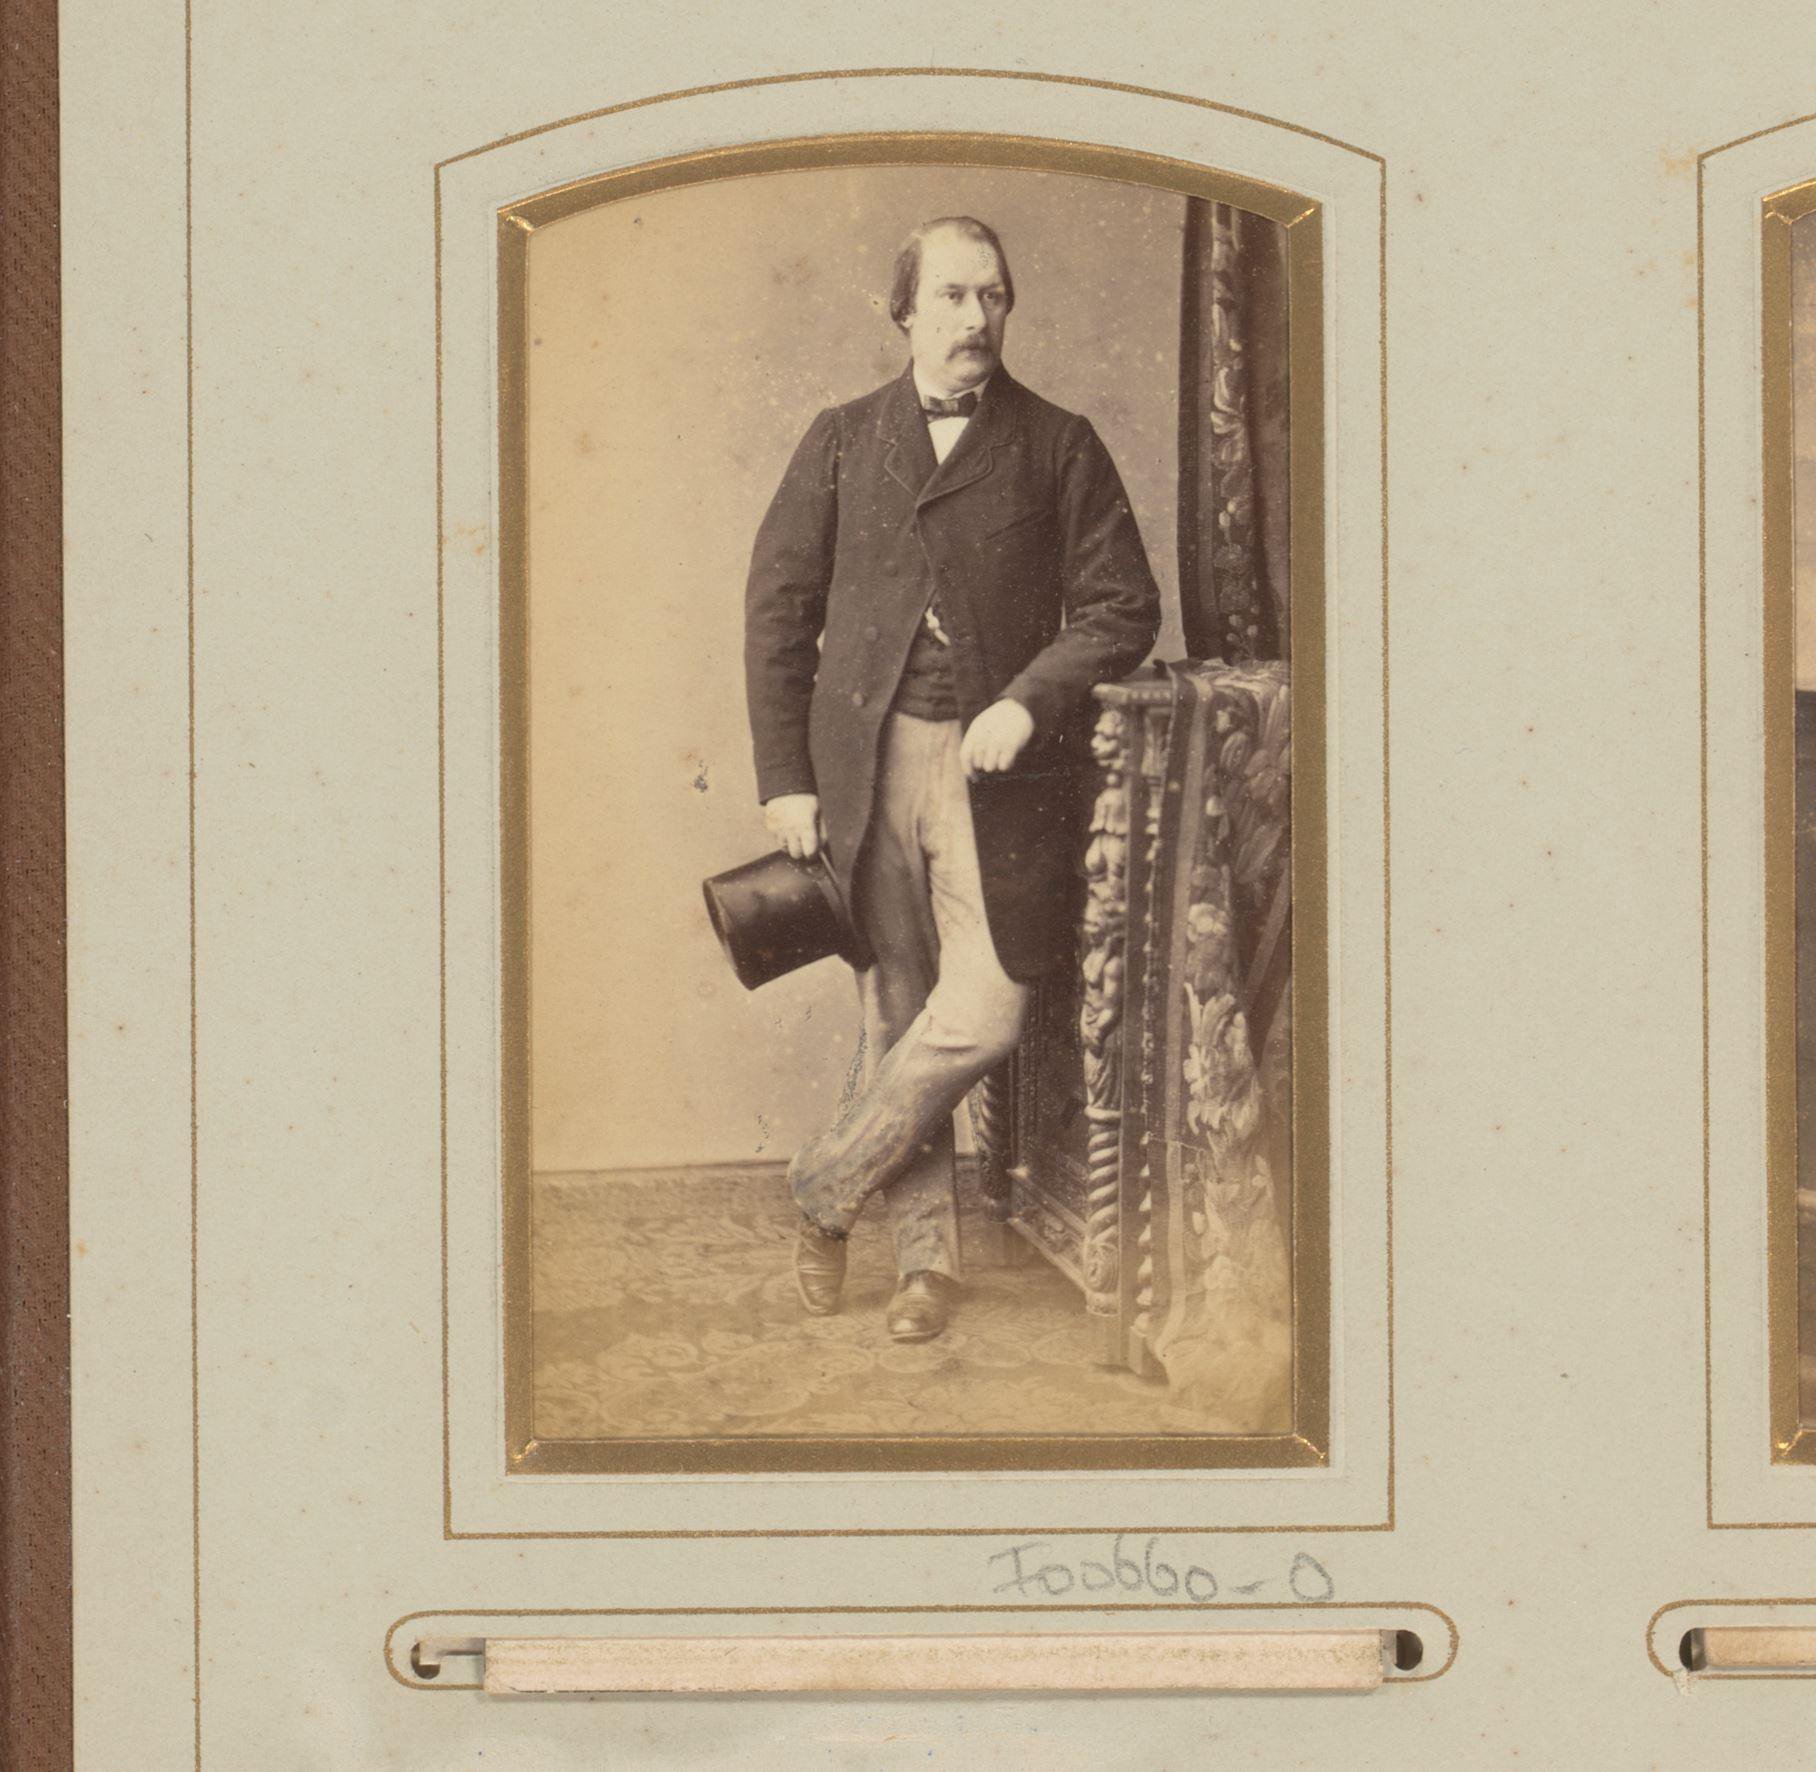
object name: album leaf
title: Portret man met hoed in de hand, leunend op een kast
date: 1860-1894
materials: cardboard, photographic support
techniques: albumen print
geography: brussels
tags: ornamental cupboard, historical persons, head-gear: top hat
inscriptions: inscription: ‘ATELIER DE PHOTOGRAPHIE./ GHÉMAR FRÈRES,/ PHOTOGRAPHES DU ROI,/ 27, rue de l'Écuyer,/ entrée par la porte cochère,/ BRUXELLES.’